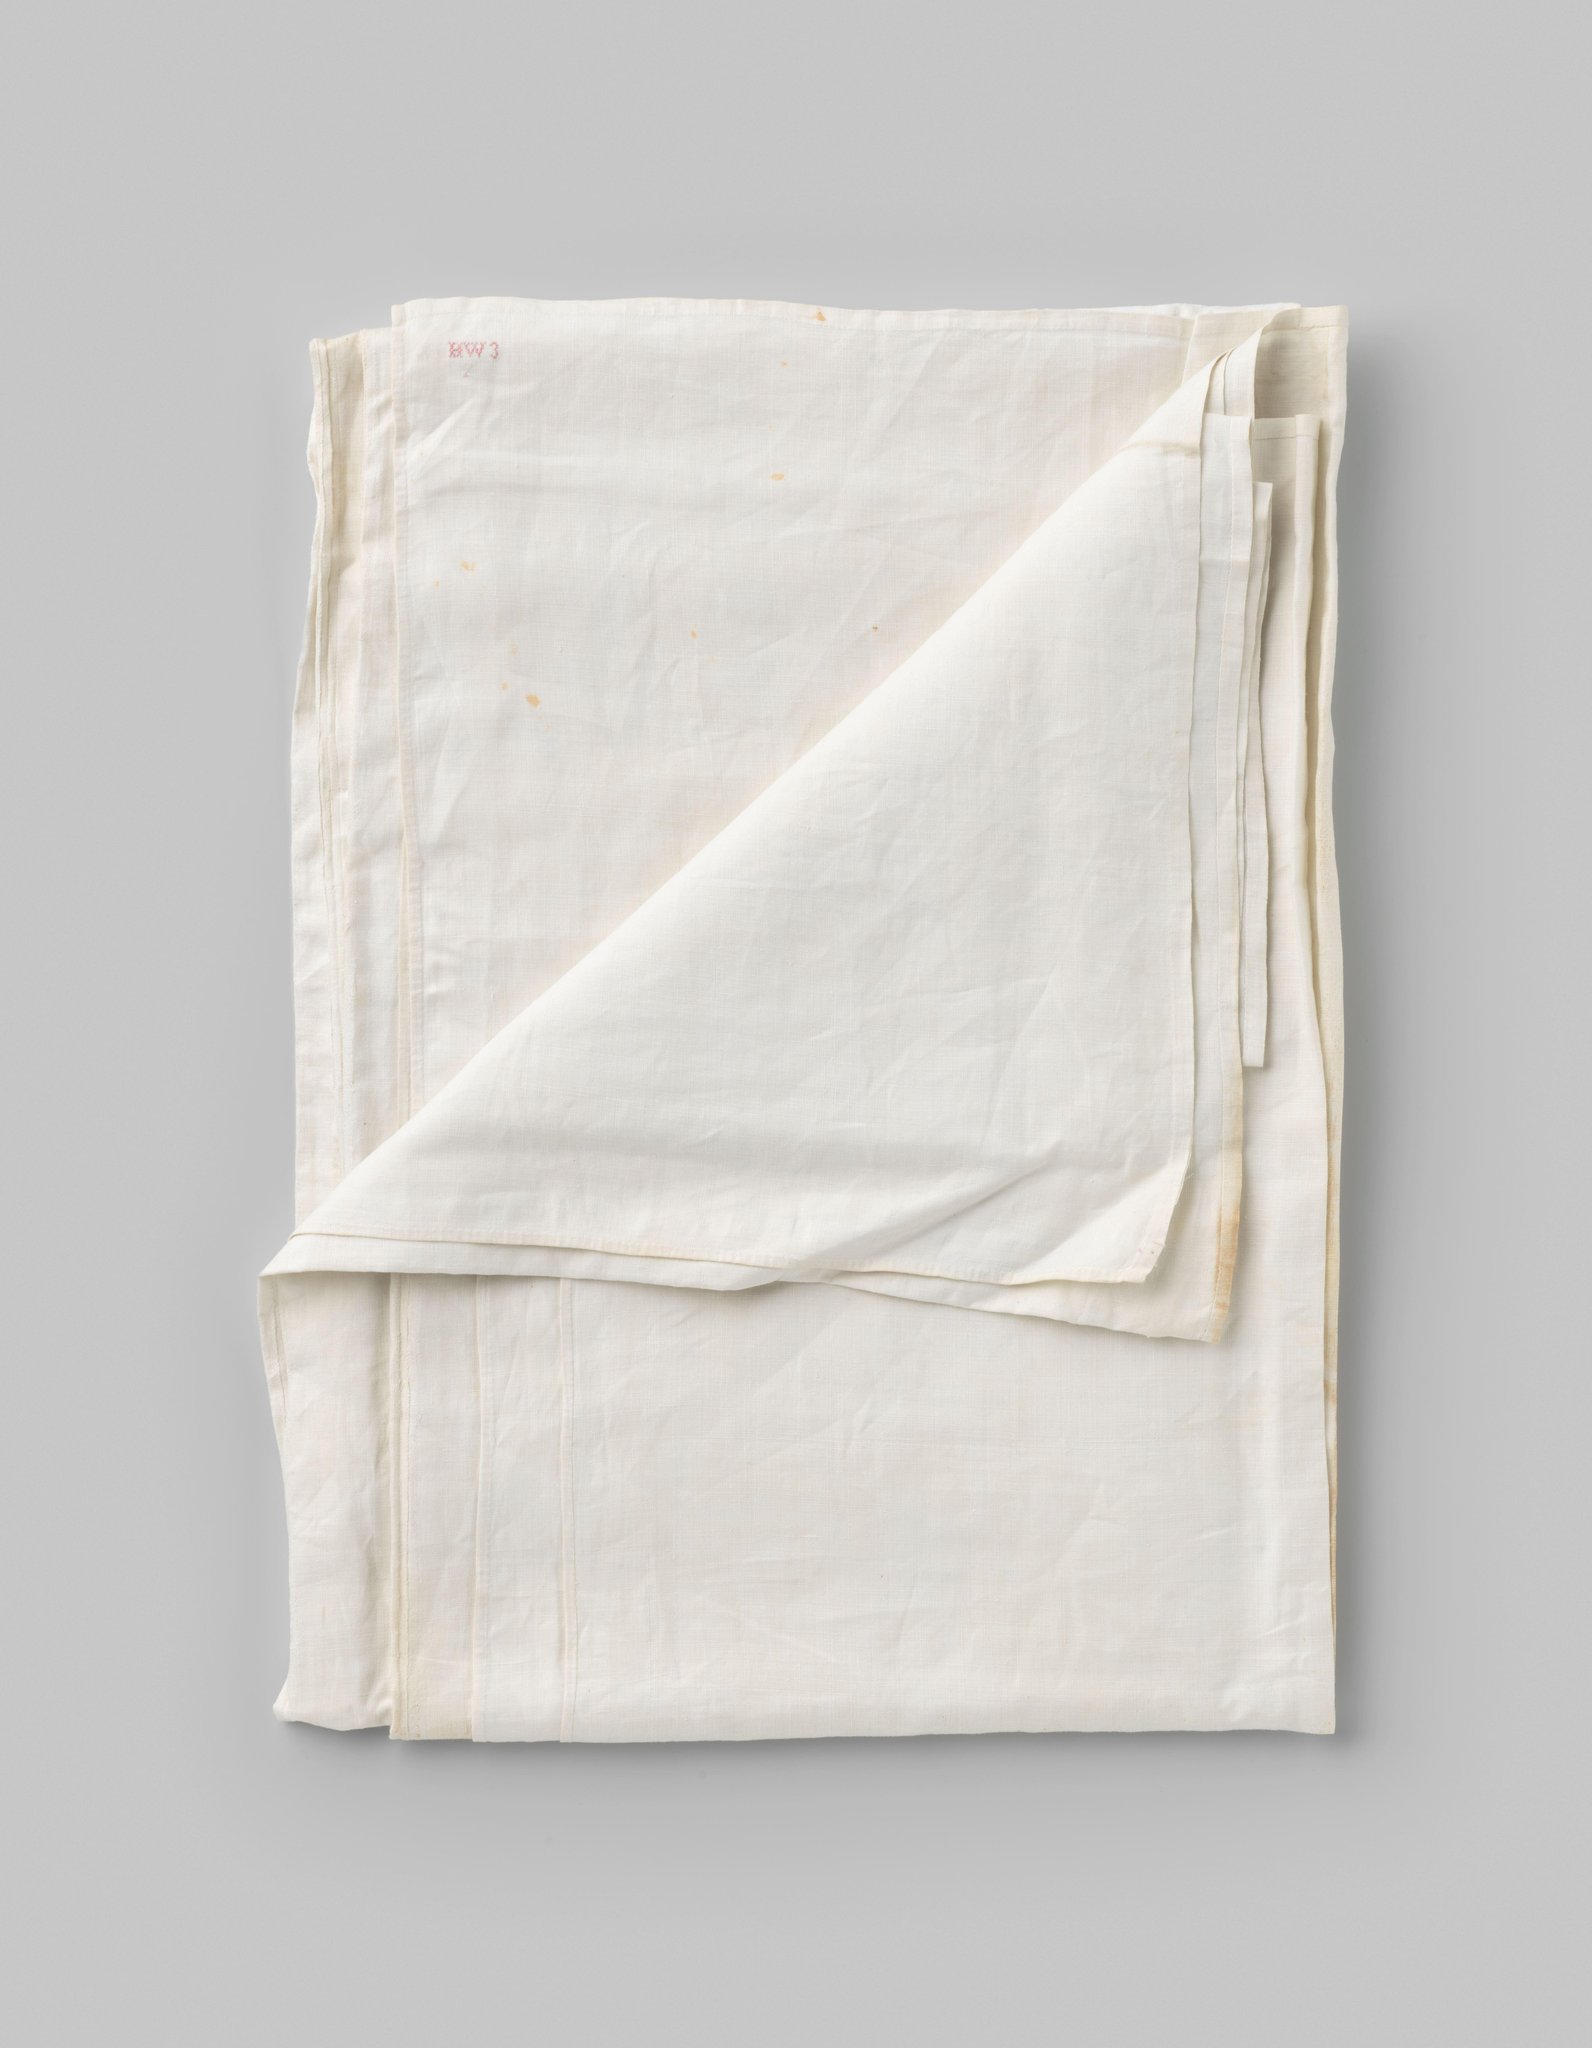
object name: beddenlaken, laken object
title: Laken. Merk: IG2 en HW32.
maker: Anonymous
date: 1730-1775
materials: linen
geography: northern netherlands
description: Laken van wit linnen, merk IG 2 en HW3 2